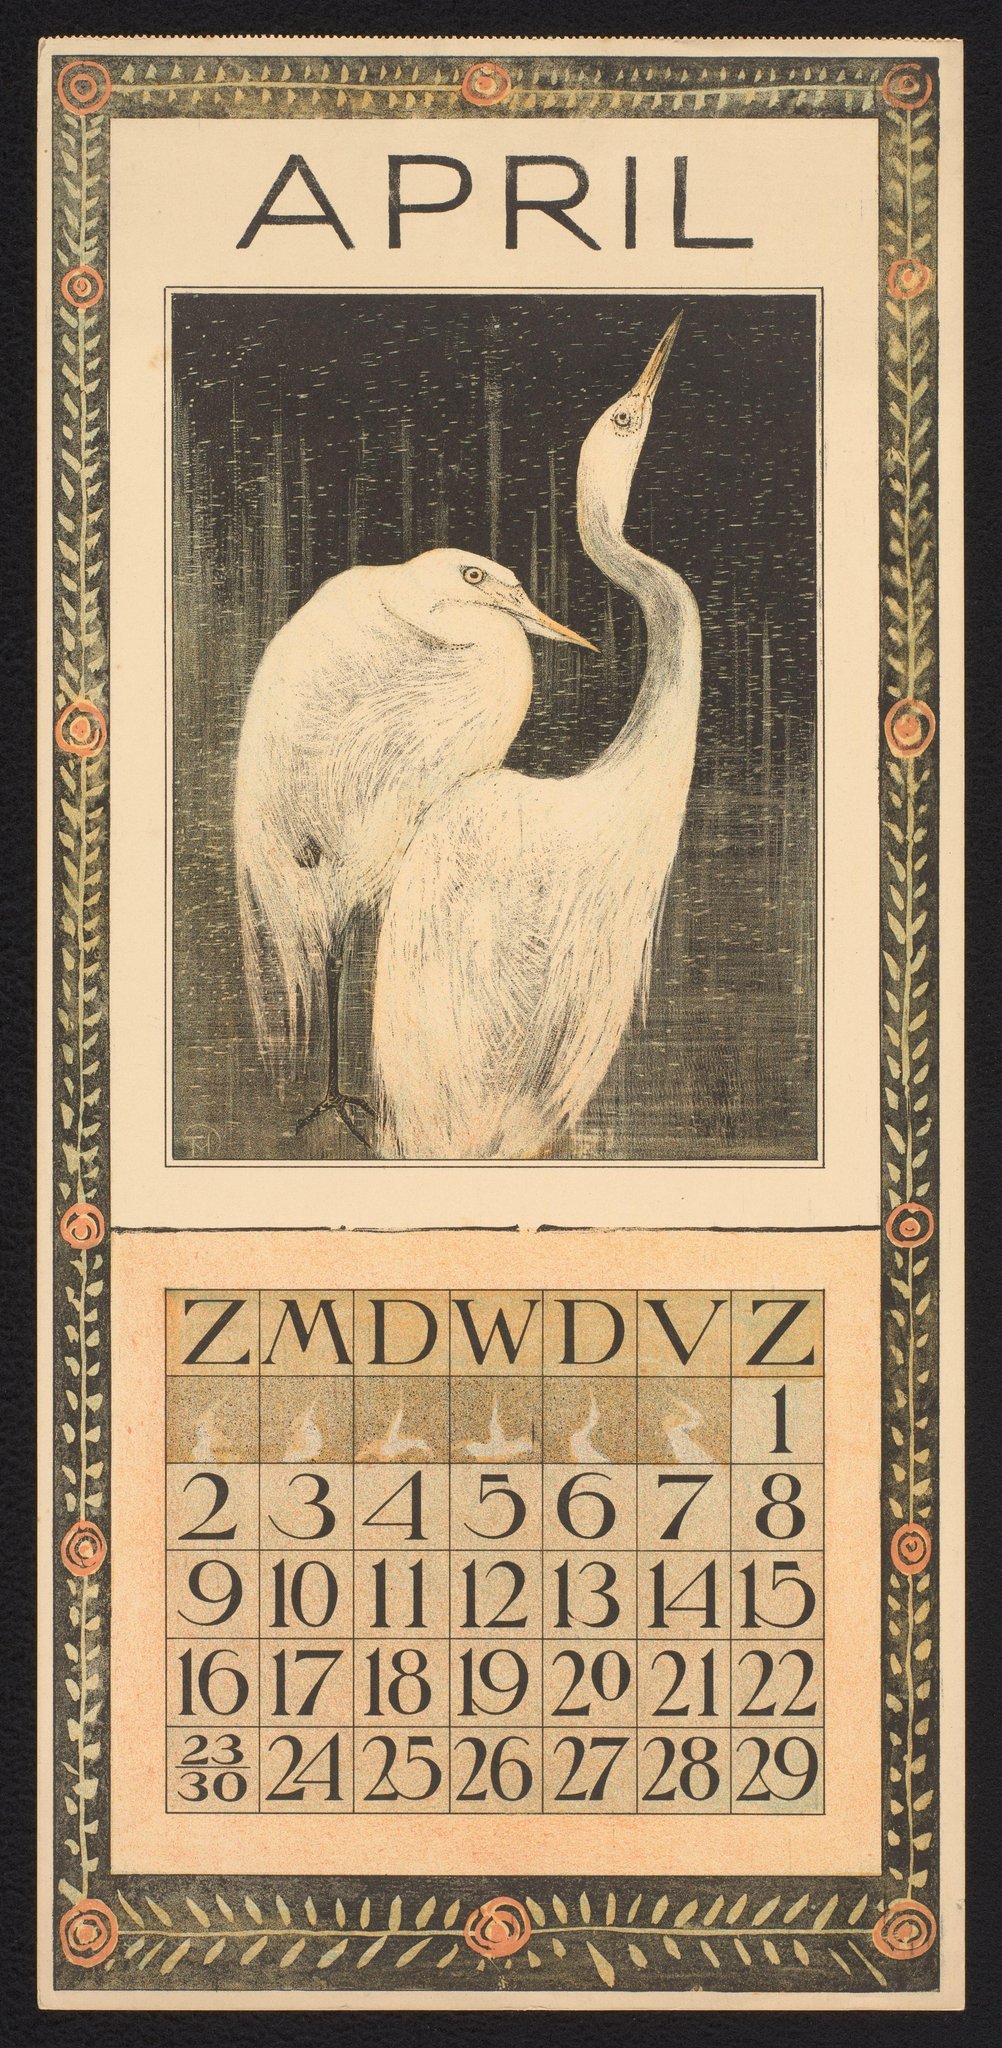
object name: print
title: Kalenderblad voor april 1905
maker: theo van hoytema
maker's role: draughtsman, painter, print maker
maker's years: 1863-1917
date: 1904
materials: paper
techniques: lithograph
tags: calendar, almanac, shore-birds and wading-birds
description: Twee zilverreigers aan de waterkant. Daaronder de maandkalender, met in de lege velden voorafgaand aan 1 april silhouetten van zilverreigers. Bovenaan een perforatierand waar dit blad verbonden was met de overige van de kalender.